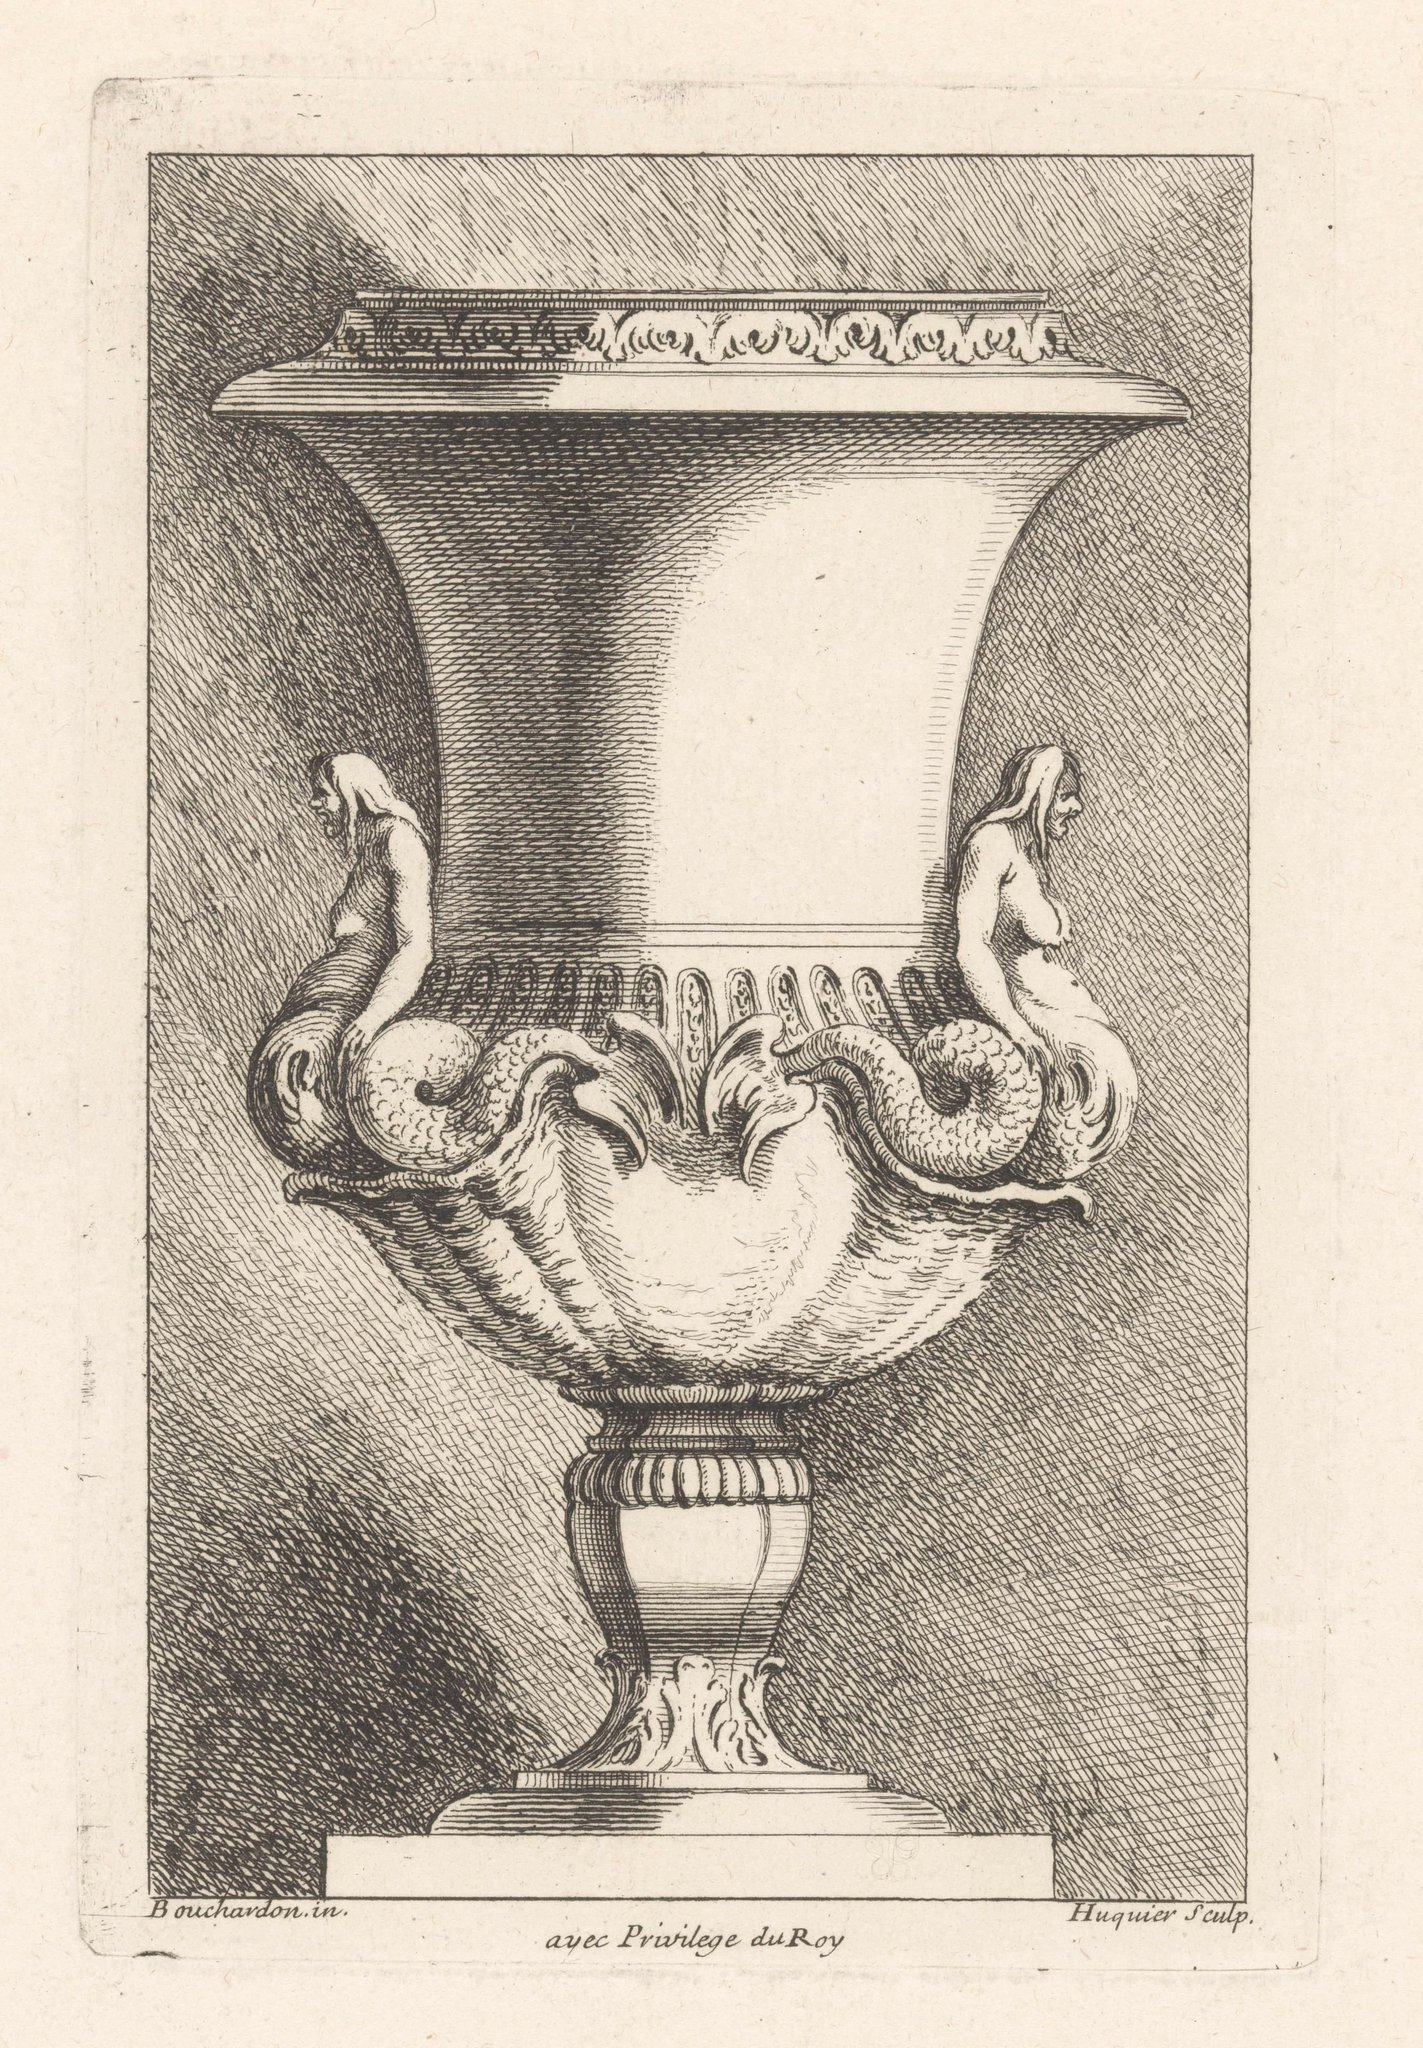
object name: ornament print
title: Second livre de vases (...)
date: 1729-1737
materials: paper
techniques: etching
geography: paris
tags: merman - aa - mermaid, siren, vase ~ ornament, scallop, shell ~ ornament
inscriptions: collector's mark: Lugt 2228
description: Een vaas met twee meerminnen in een schelp.